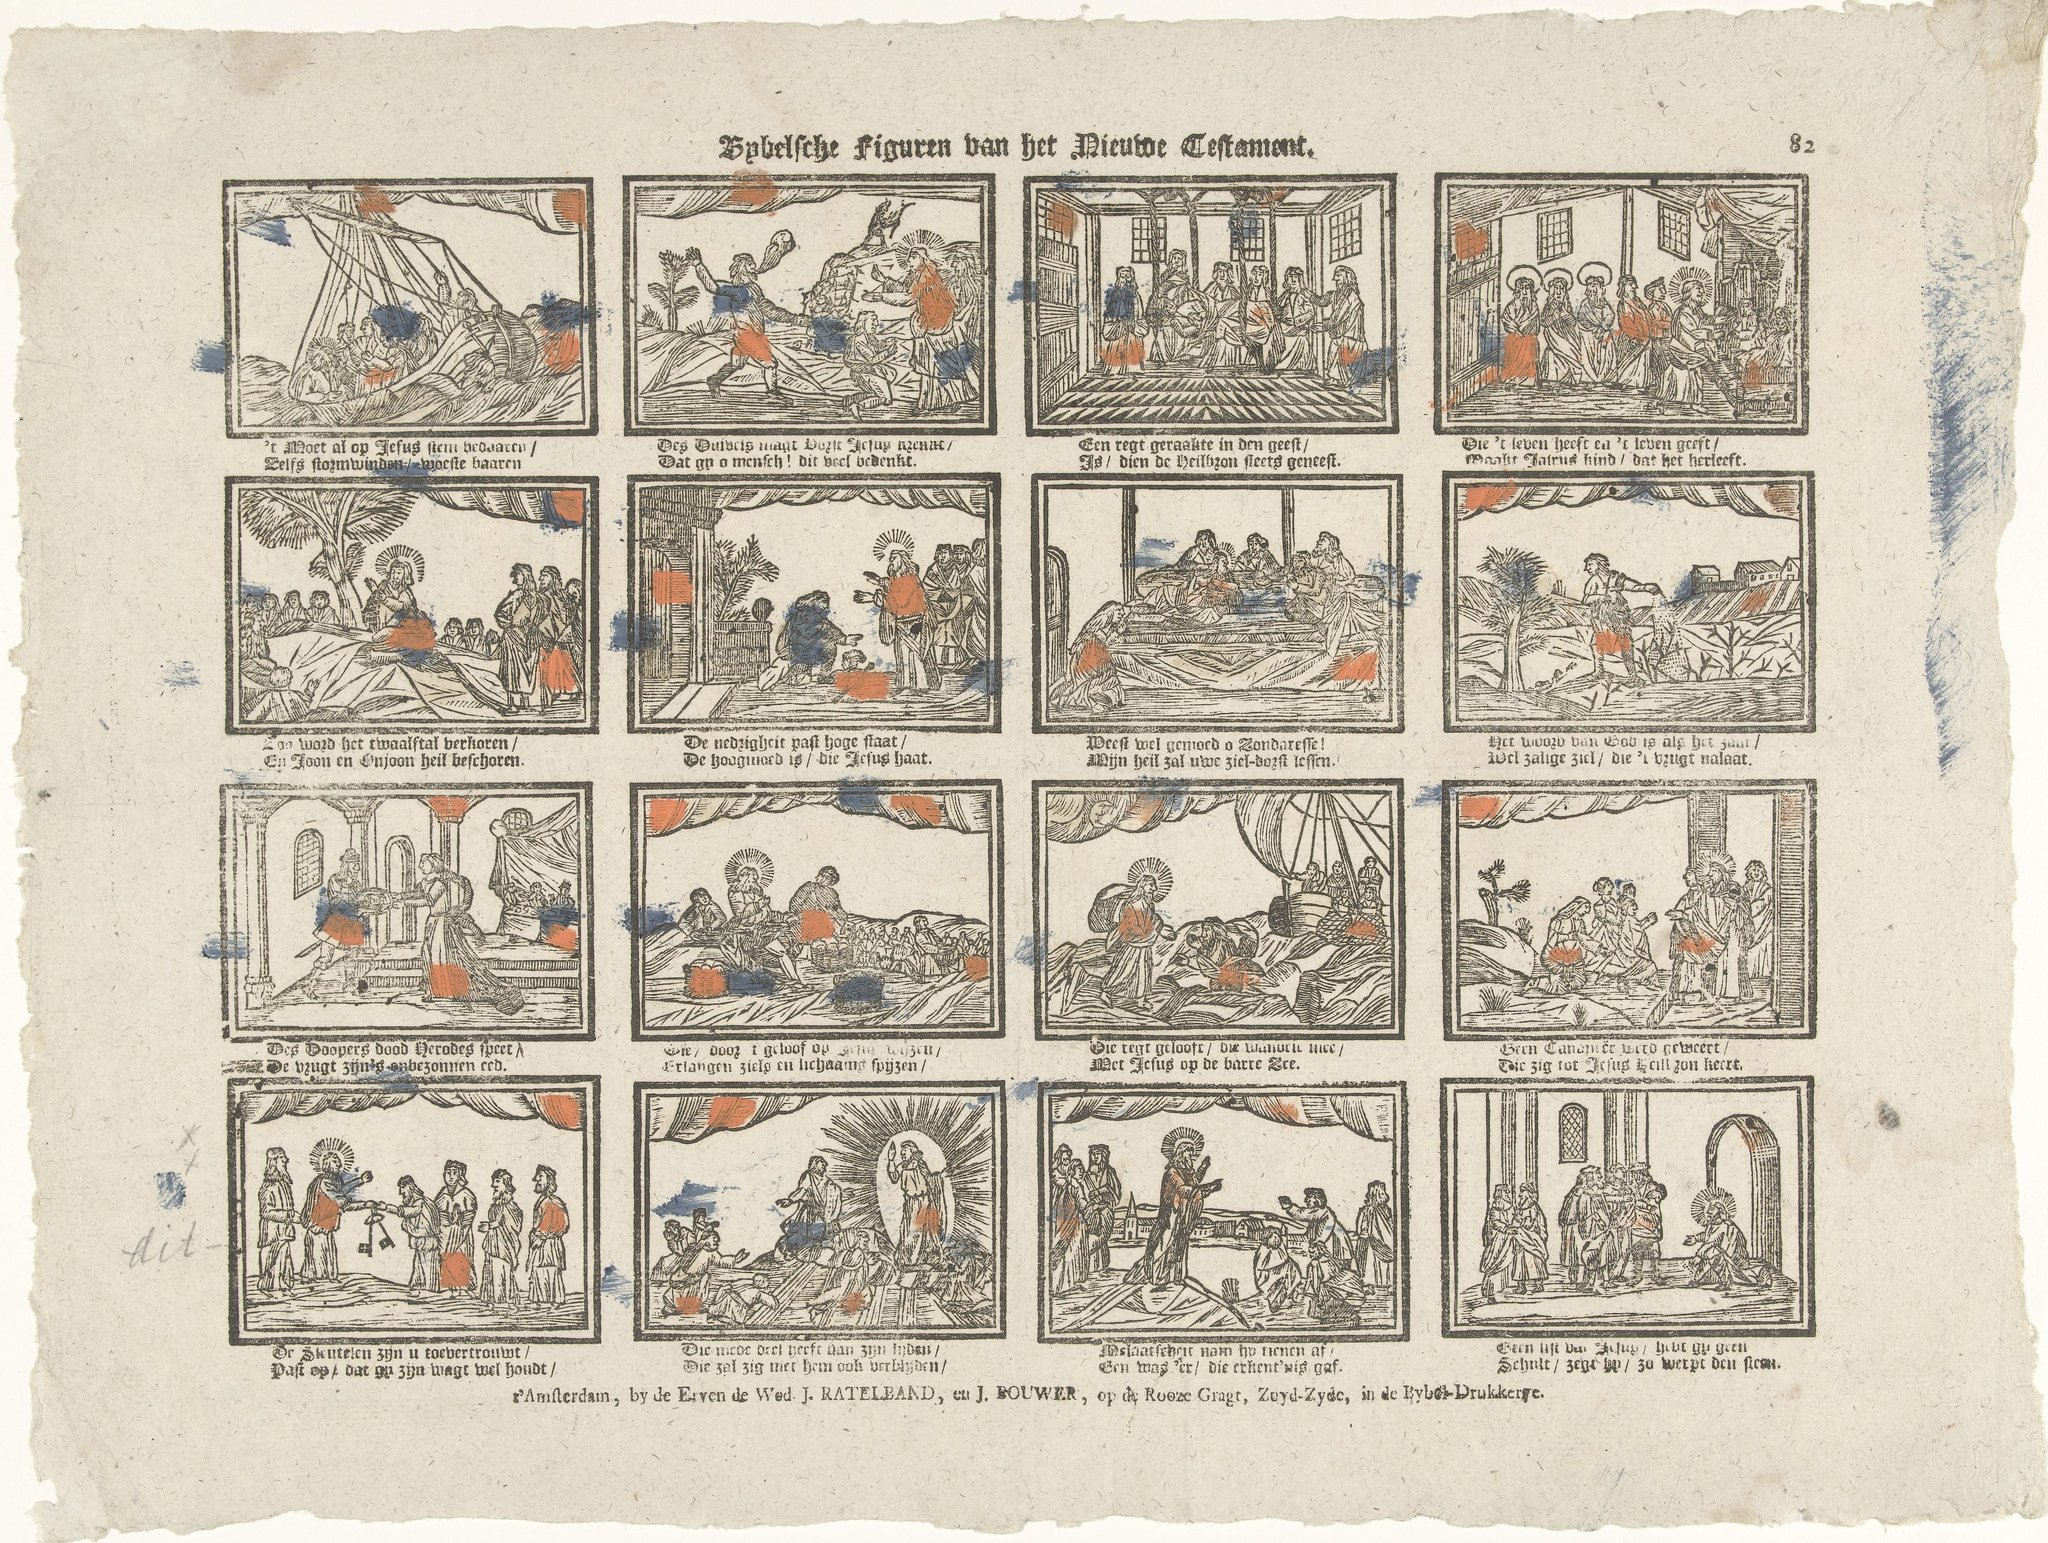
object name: print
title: Bybelsche figuren van het Nieuwe Testament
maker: Anonymous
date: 1782-1793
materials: paper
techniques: colour, letterpress printing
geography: netherlands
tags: new testament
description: Blad met 16 voorstellingen van verhalen uit het Nieuwe Testament. Onder elke afbeelding een tweeregelig vers. Genummerd rechtsboven: 82.